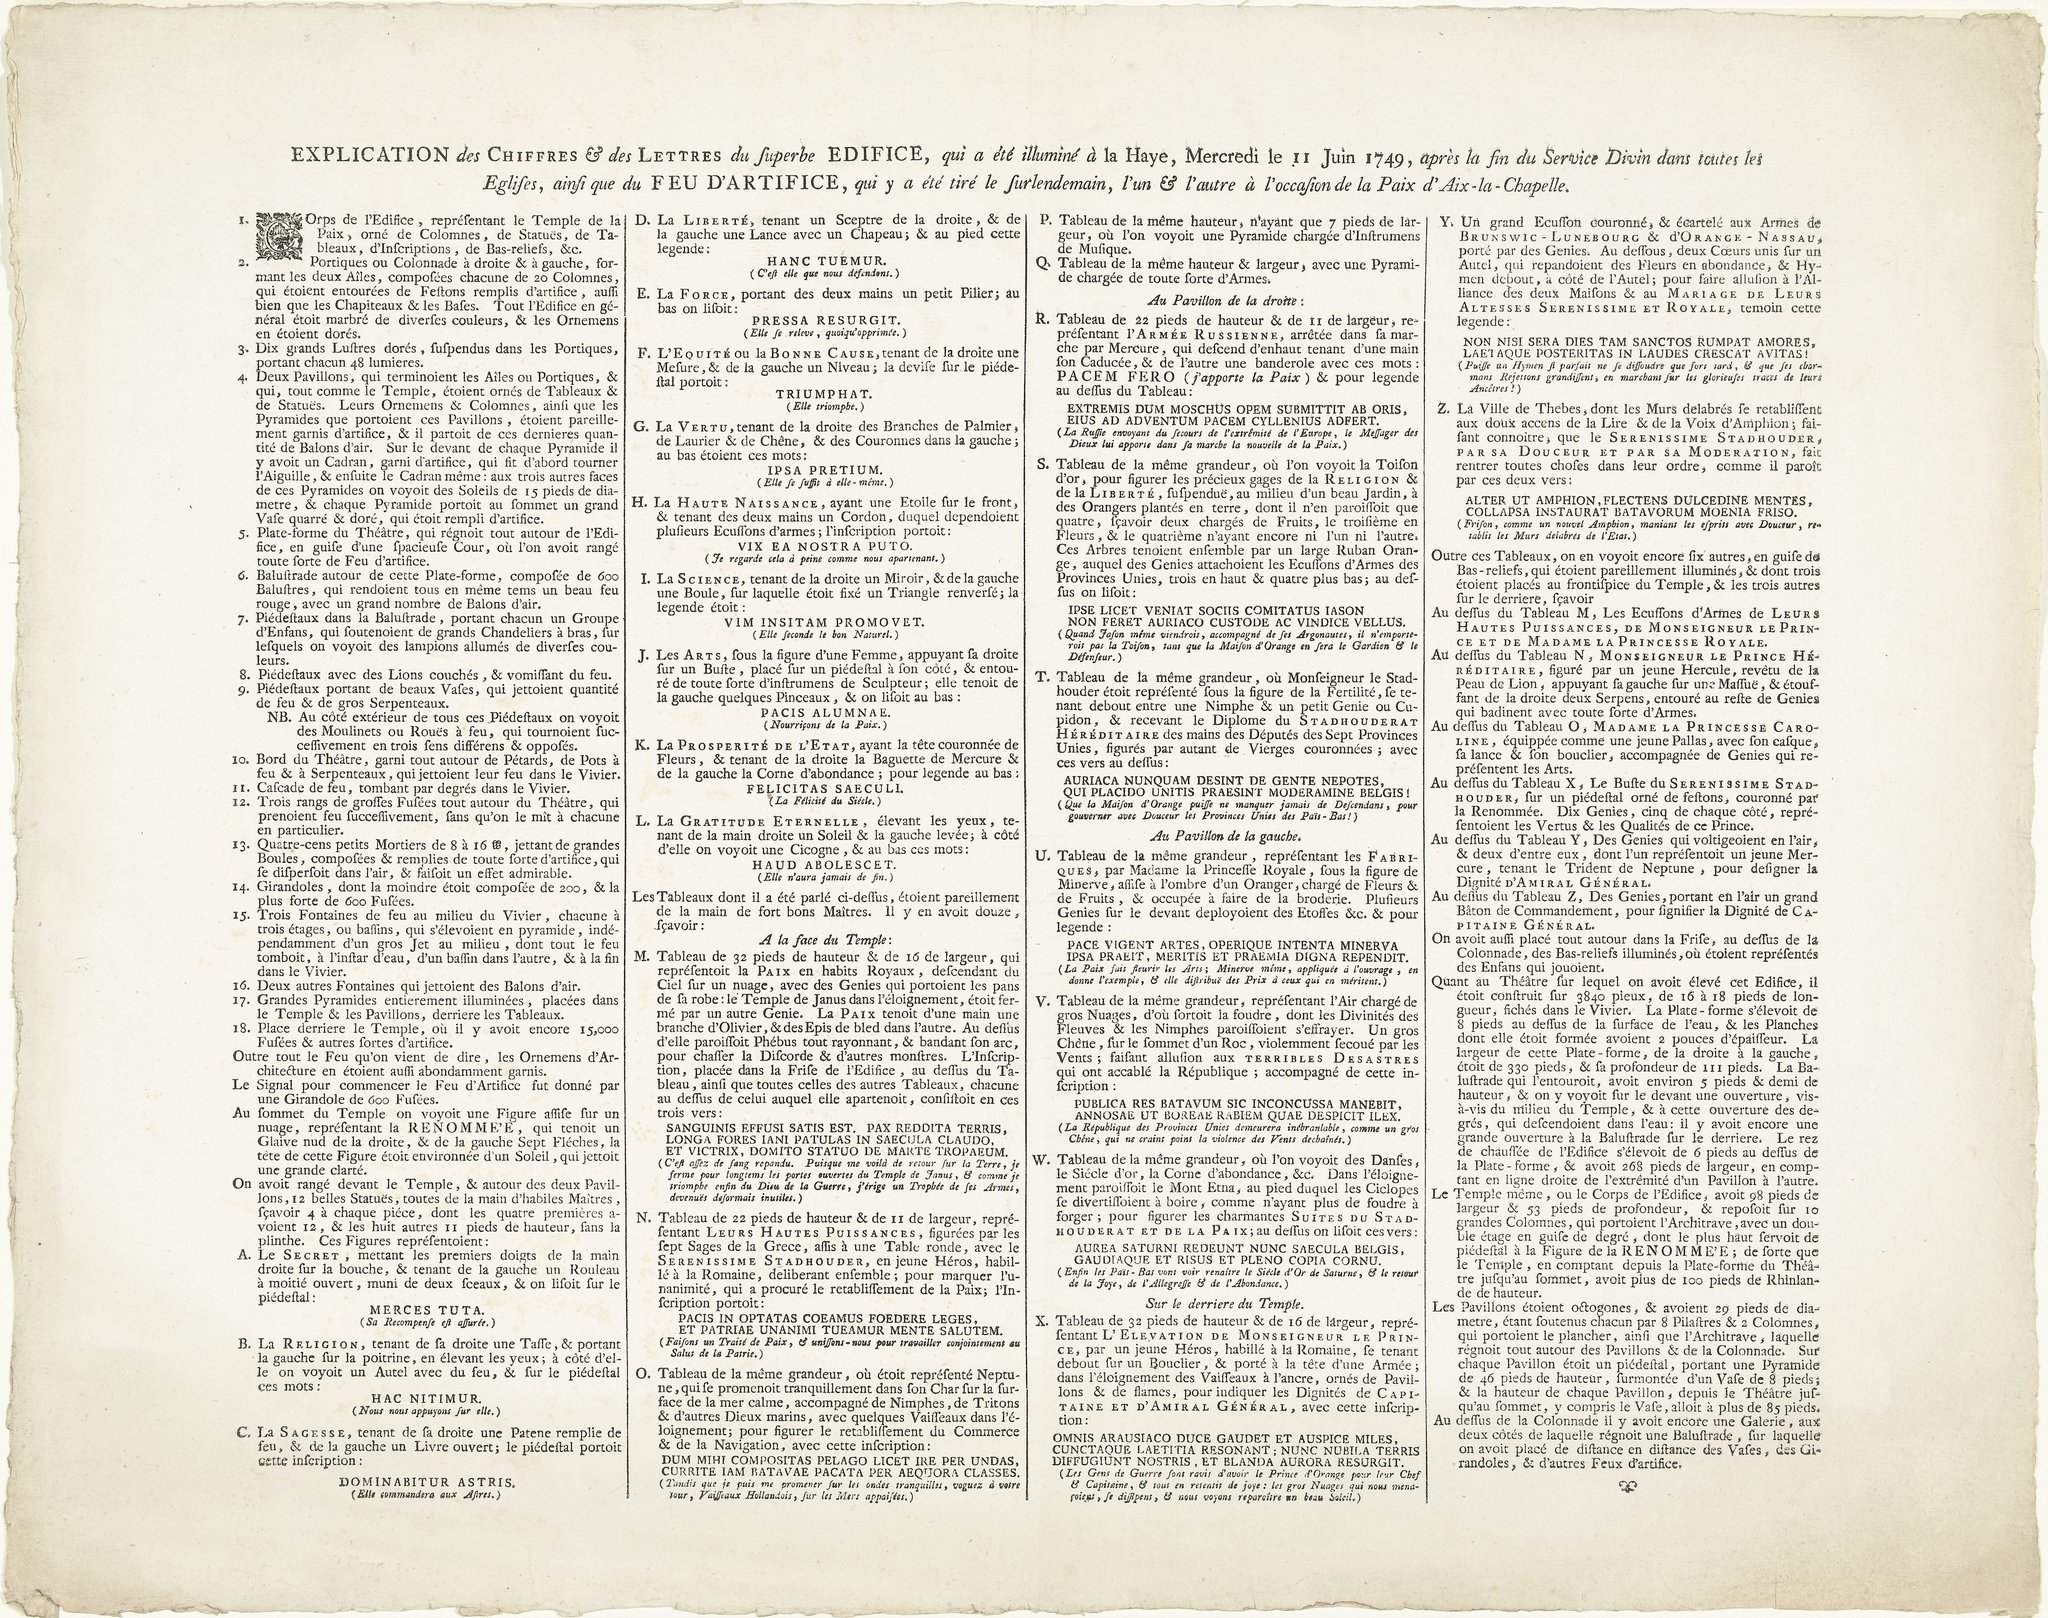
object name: text sheet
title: Verklarende tekst behorend bij voorstelling met het vuurwerkpaviljoen te Den Haag gebouwd ter gelegenheid van de feestelijkheden rond het sluiten van de Vrede van Aken op 11 juni 1749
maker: Anonymous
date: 1749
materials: paper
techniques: letterpress printing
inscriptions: date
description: Verklarende tekst in boekdruk behorend bij voorstelling met het vuurwerkpaviljoen te Den Haag gebouwd ter gelegenheid van de feestelijkheden rond het sluiten van de Vrede van Aken op 11 juni 1749. De cijfers en letters verwijzen naar details van het paviljoen en de omgeving.